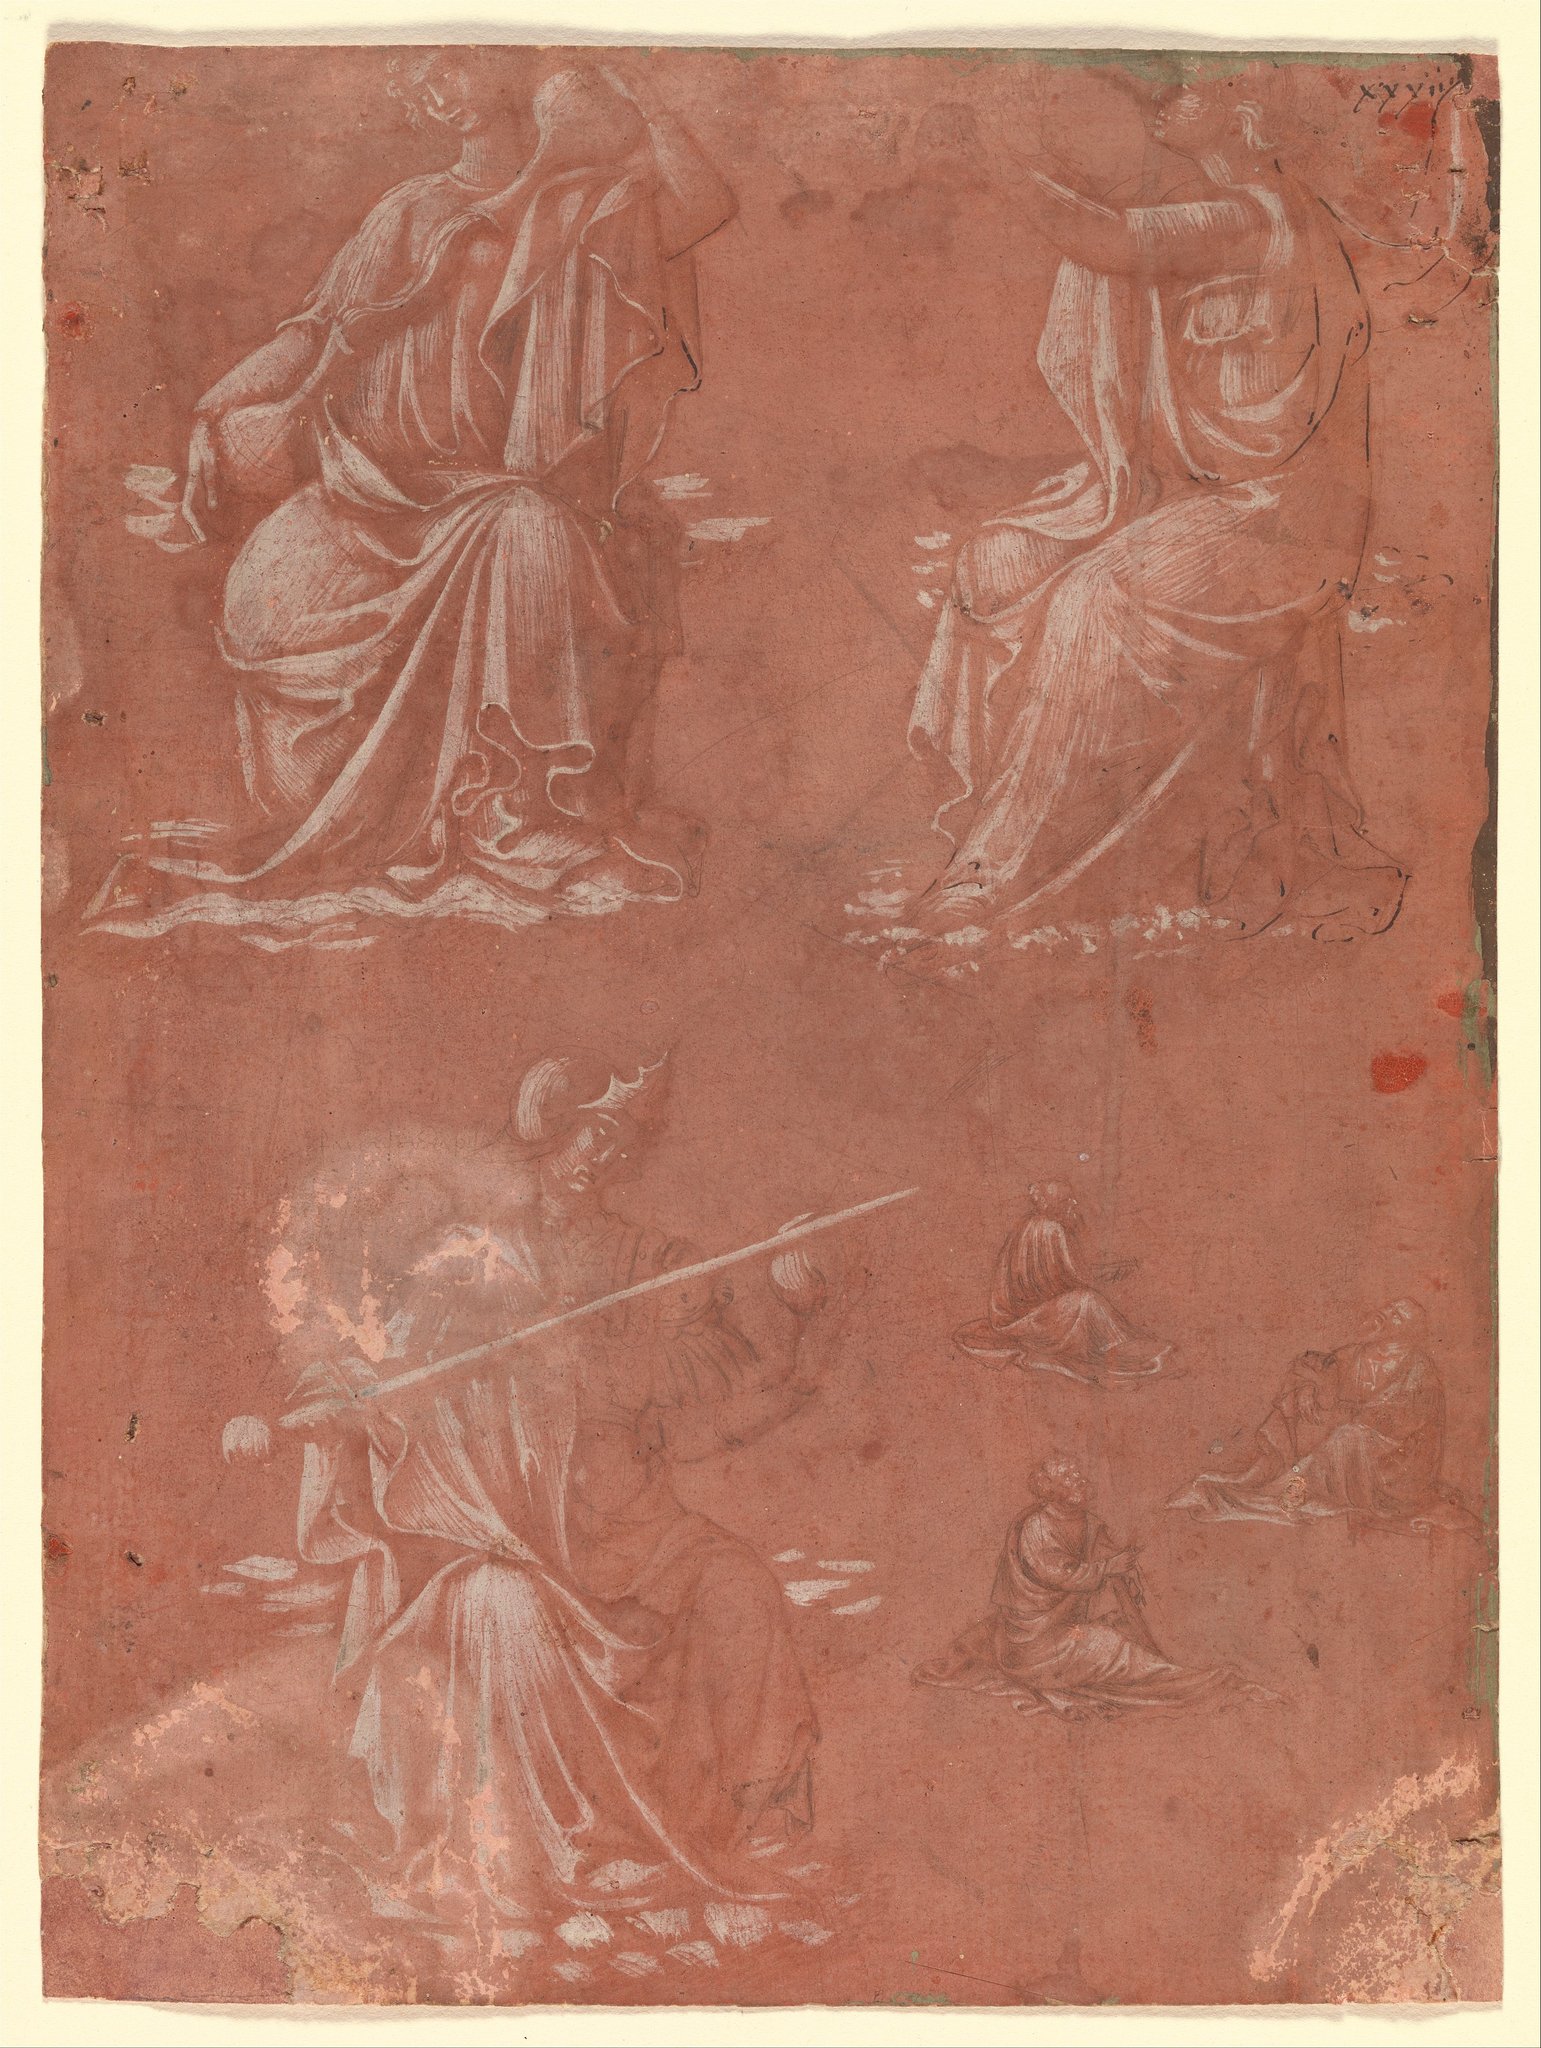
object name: drawing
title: Three Virtues (Temperance, Hope, and Fortitude or Justice) and Studies of a Seated Man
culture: italian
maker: lorenzo monaco (piero di giovanni)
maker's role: artist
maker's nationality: italian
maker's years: 1370-1425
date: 1420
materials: ink, paper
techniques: brush, heightening, pen, wash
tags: men